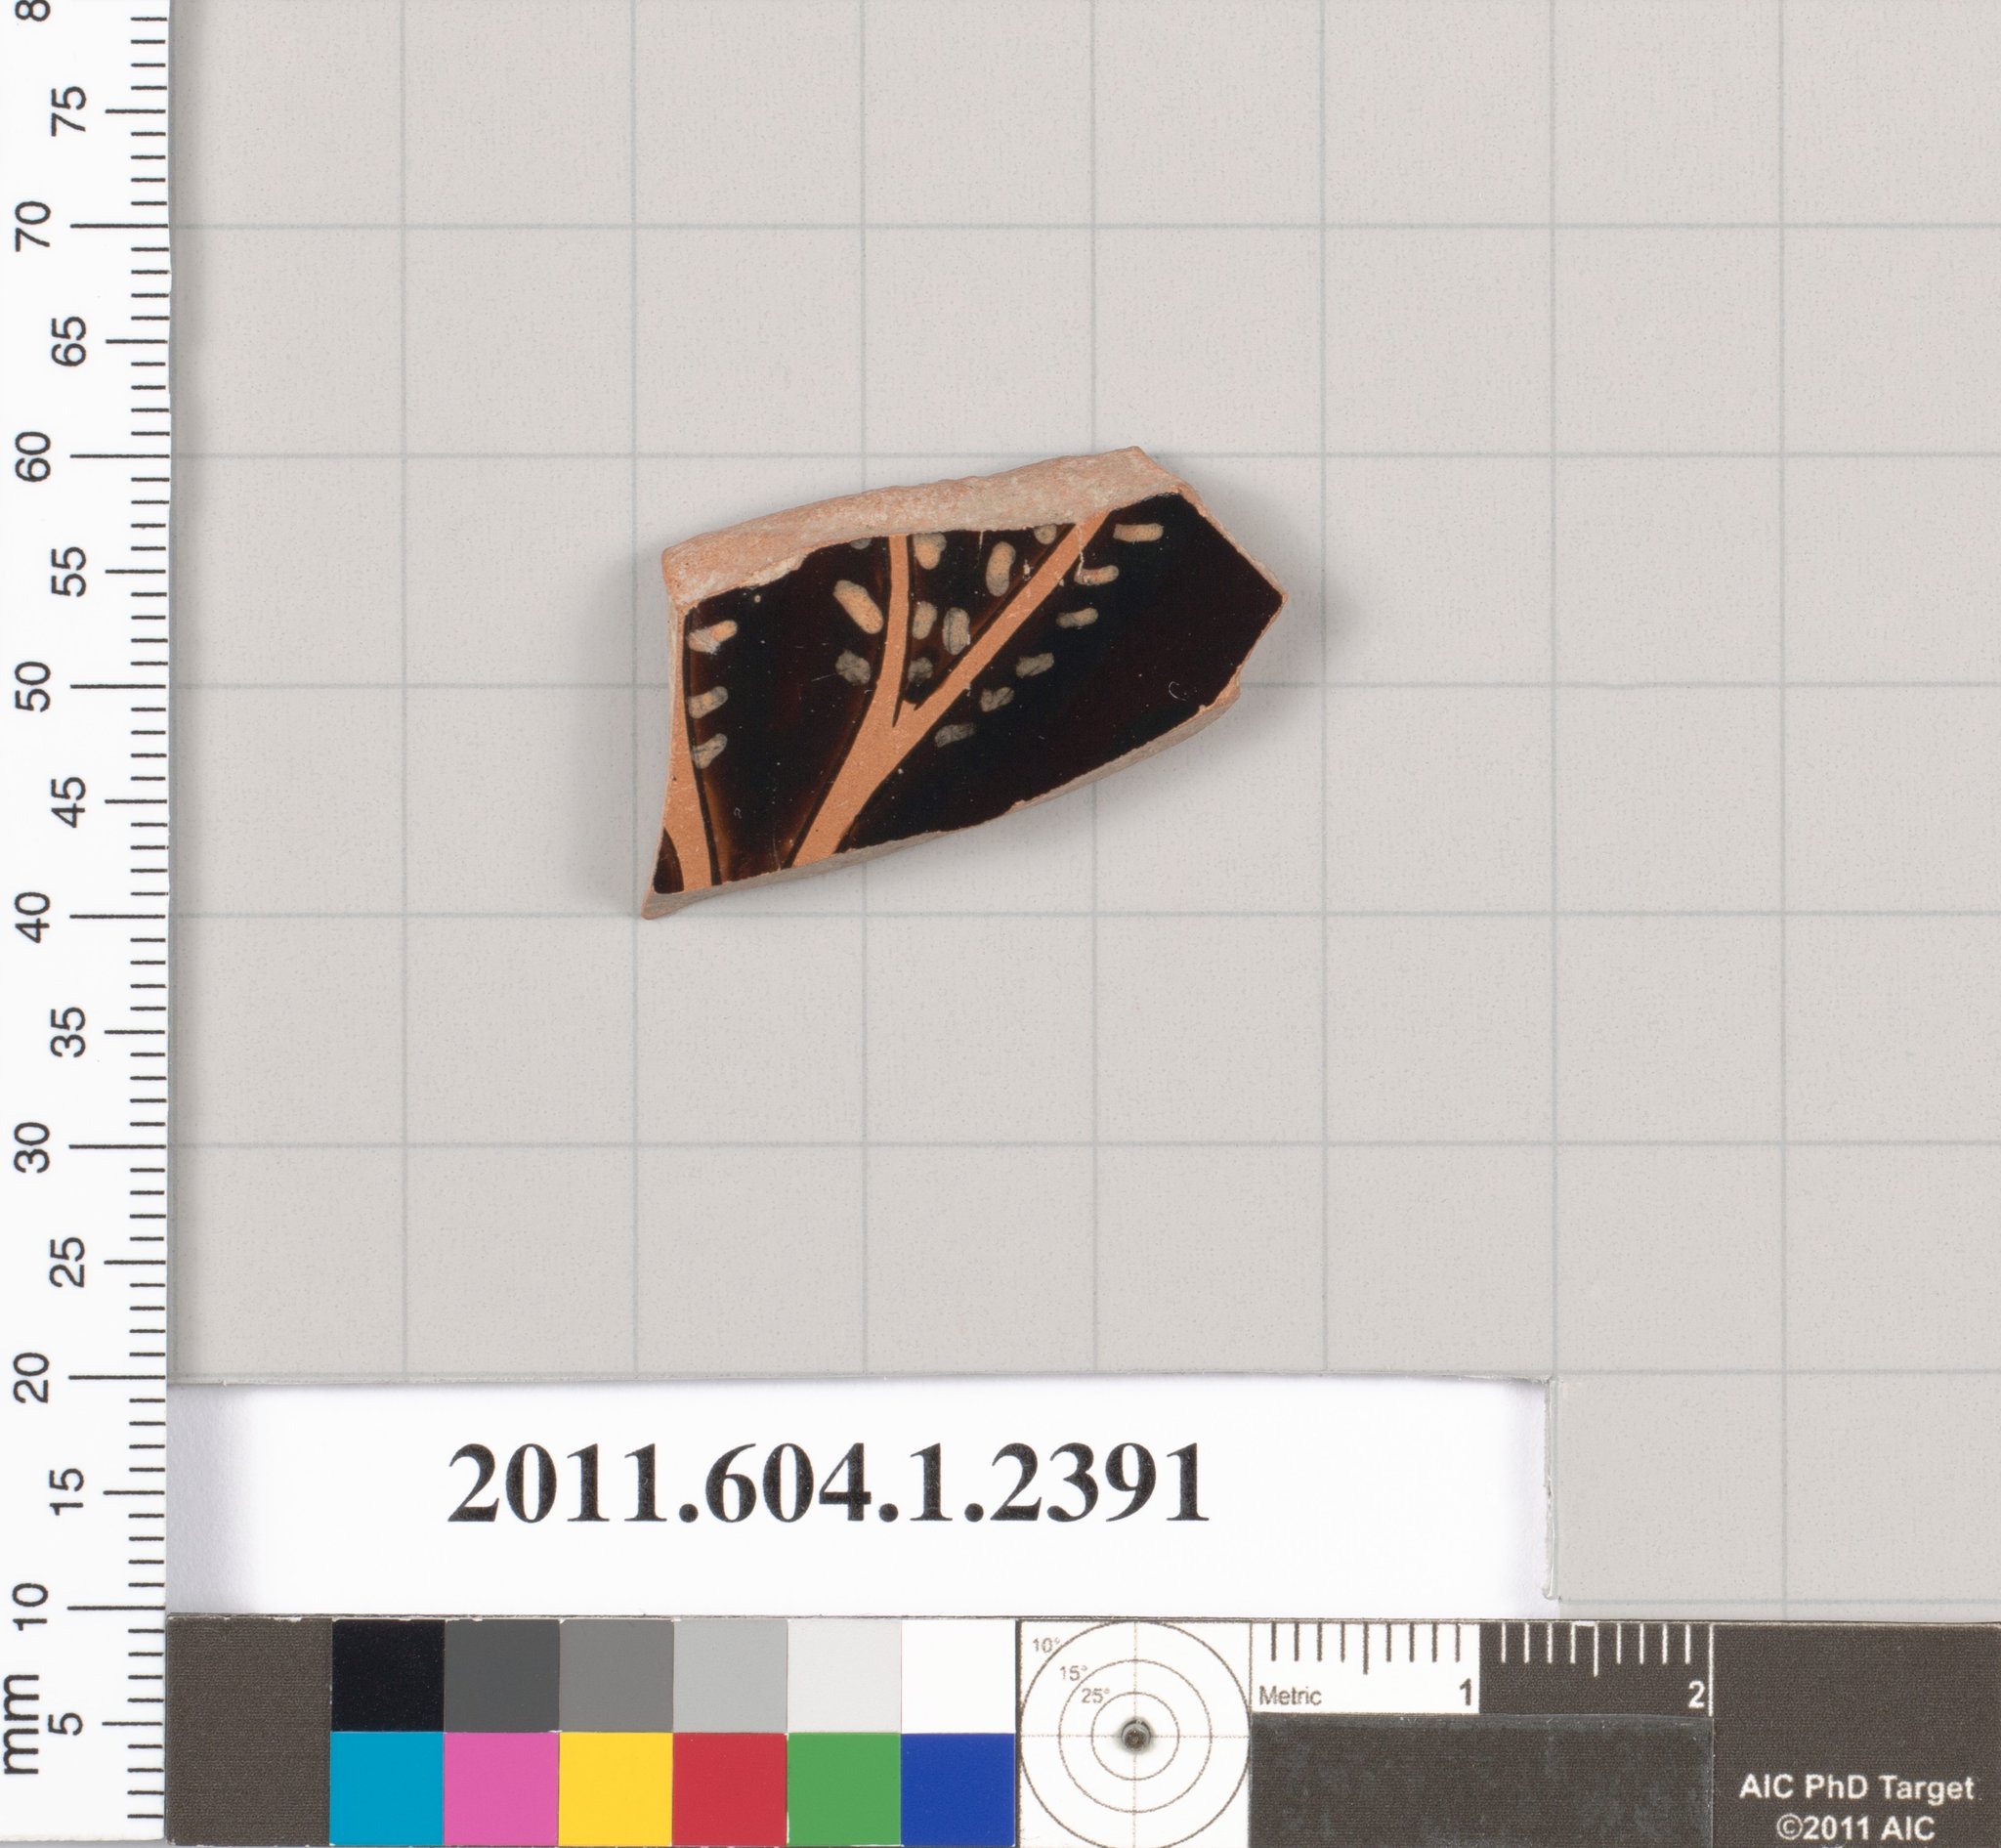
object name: kylix fragment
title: Terracotta fragment of a kylix (drinking cup)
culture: greek, attic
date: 510-490 BCE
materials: terracotta